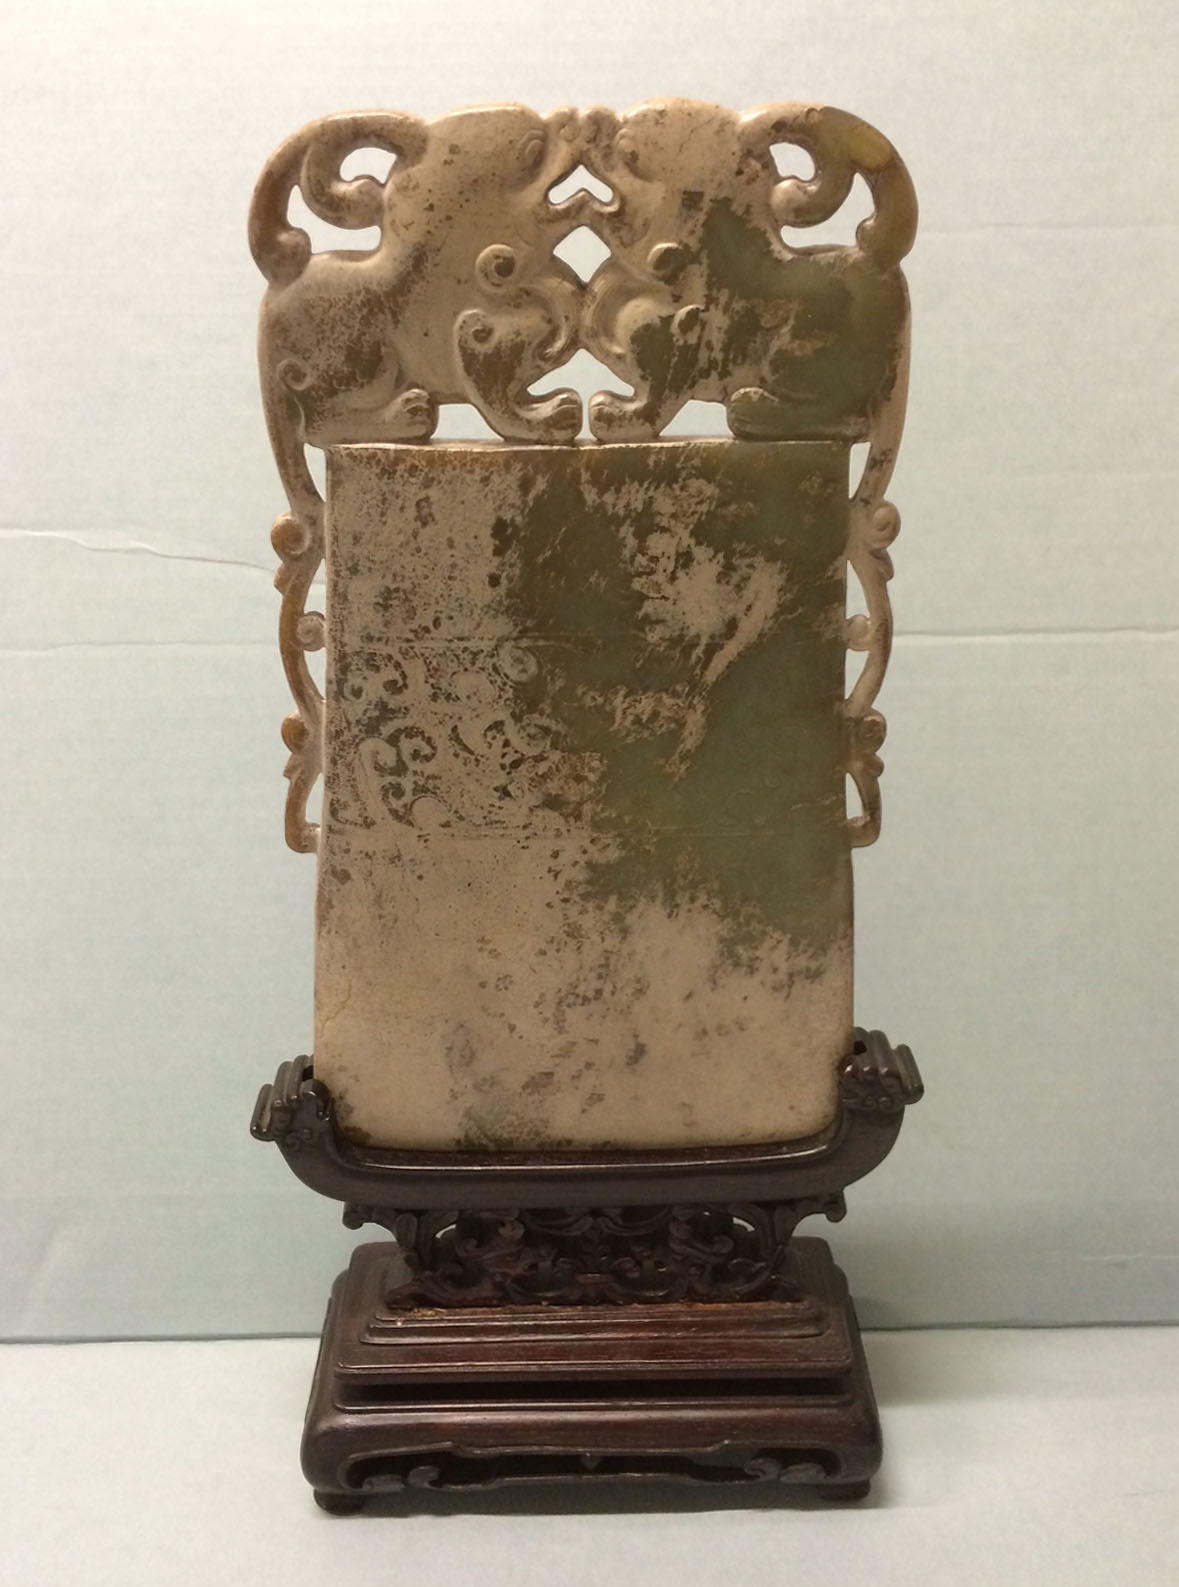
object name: ceremonial blade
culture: chinese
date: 1801-1900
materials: jade